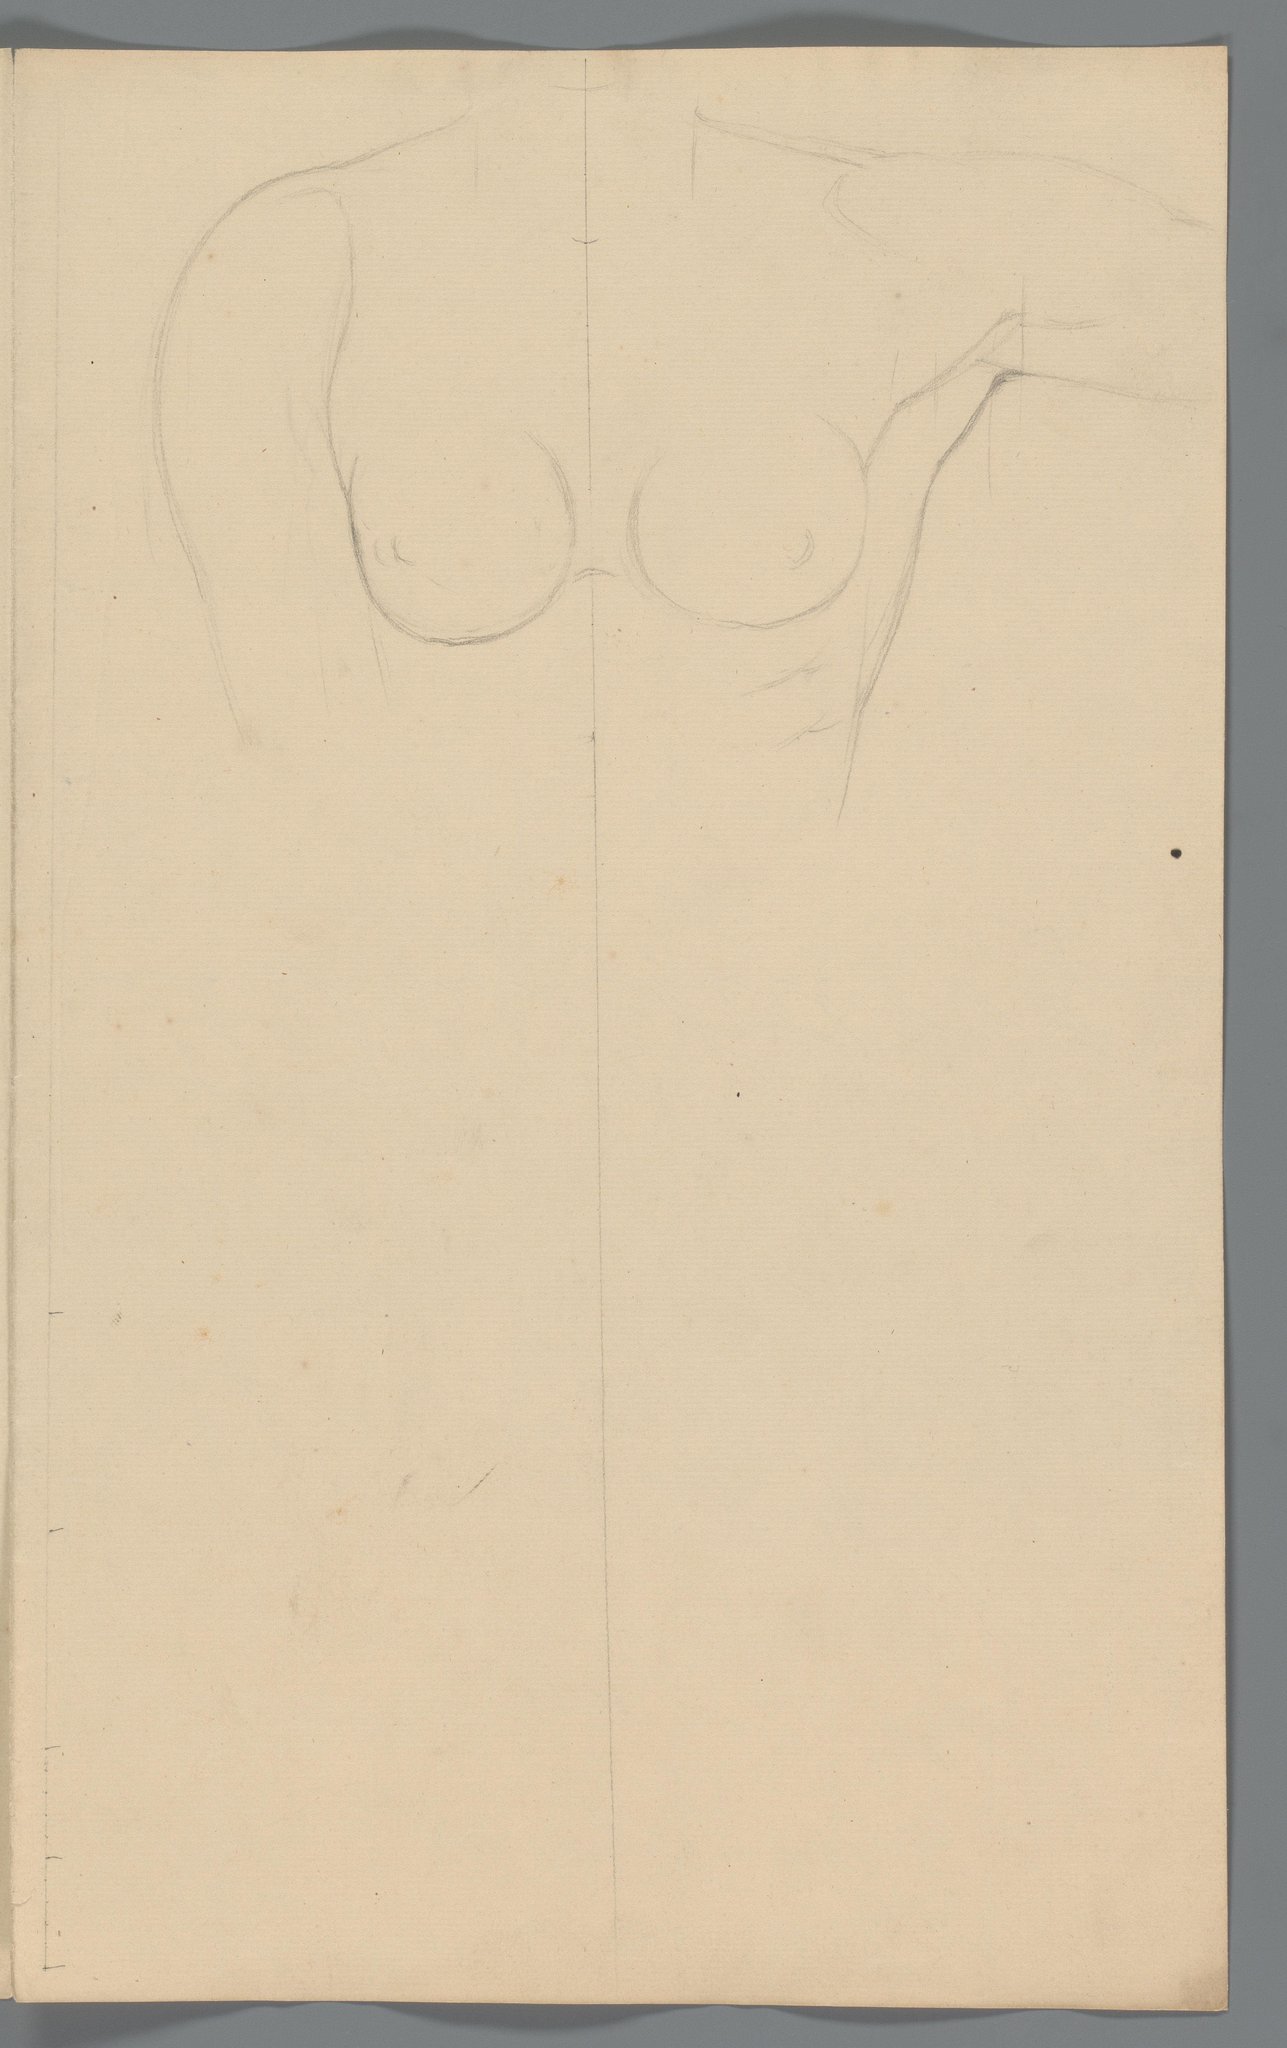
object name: drawing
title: Studie van een ontbloot bovenlijf van een vrouw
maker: jacobus everhardus josephus van den berg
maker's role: draughtsman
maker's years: 1802-1861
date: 1812-1861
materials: paper, pencil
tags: chest, bust - aa - female human figure